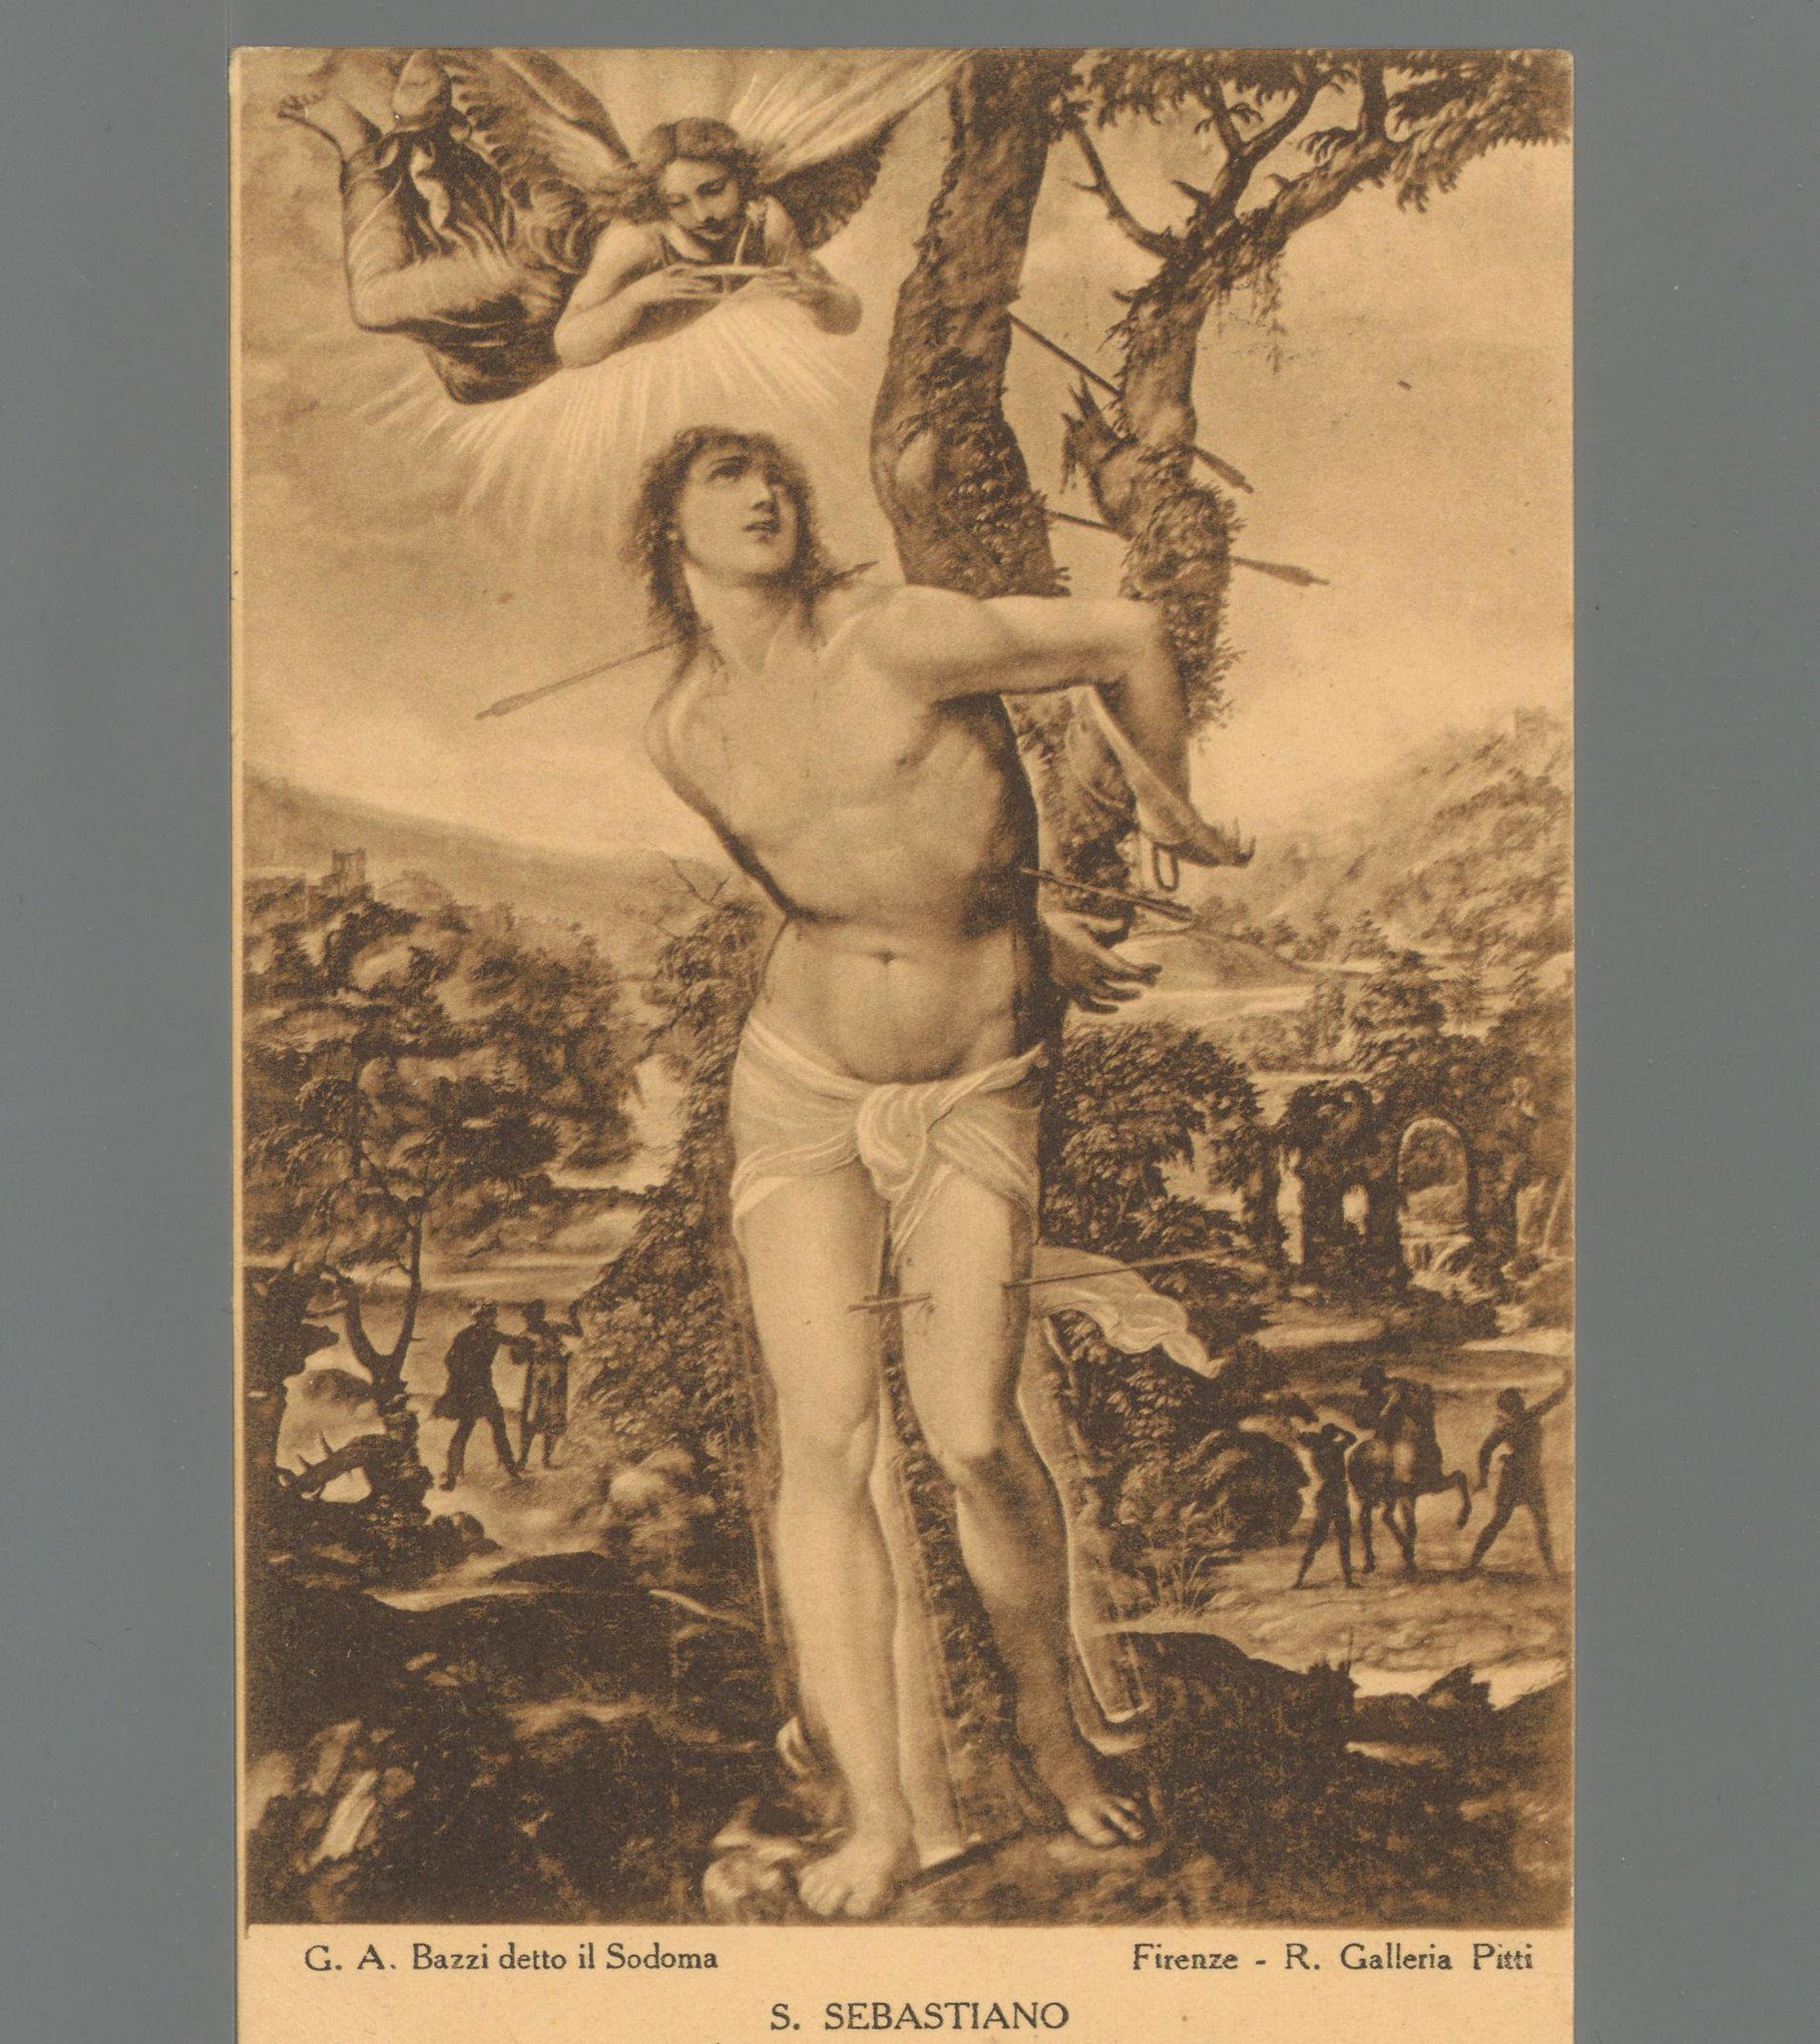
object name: reproduction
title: G.A. Bazzi detto il Sodoma. Firenze - R. Galleria Pitti. S. Sebastiano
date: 1906-1930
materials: cardboard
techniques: photograph, writing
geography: florence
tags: permanent exhibition, museum, picture, painting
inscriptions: collector's mark: ‘AFE v S’, postage stamp